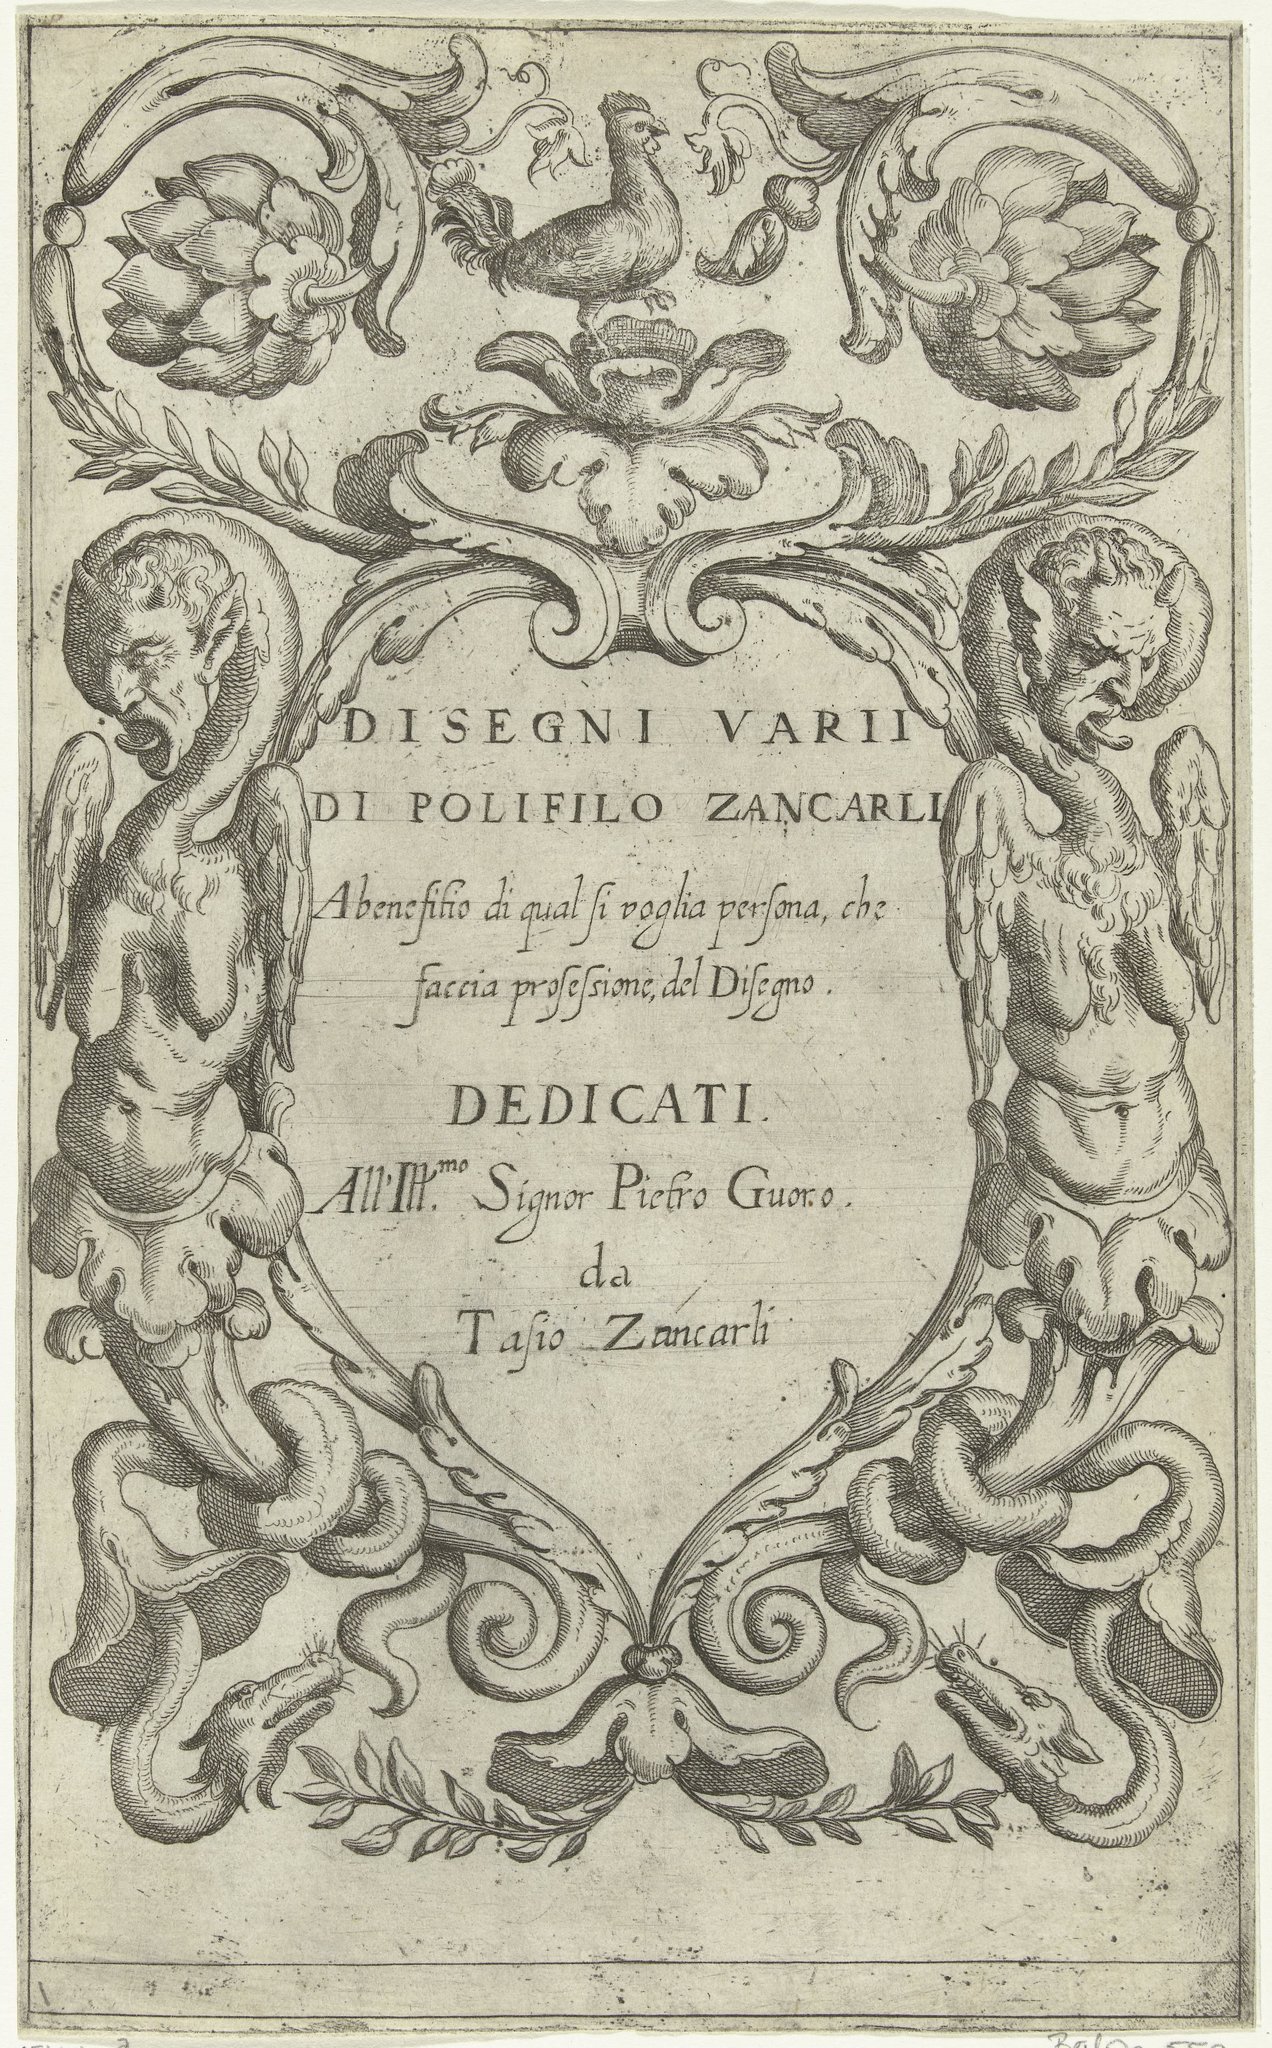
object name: print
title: Disegni varii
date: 1625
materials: paper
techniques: etching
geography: venice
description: De titel staat in een cartouche met bovenop een haan. Titelblad uit serie van 10 bladen met verticale panelen vol bladranken, figuren en dieren.